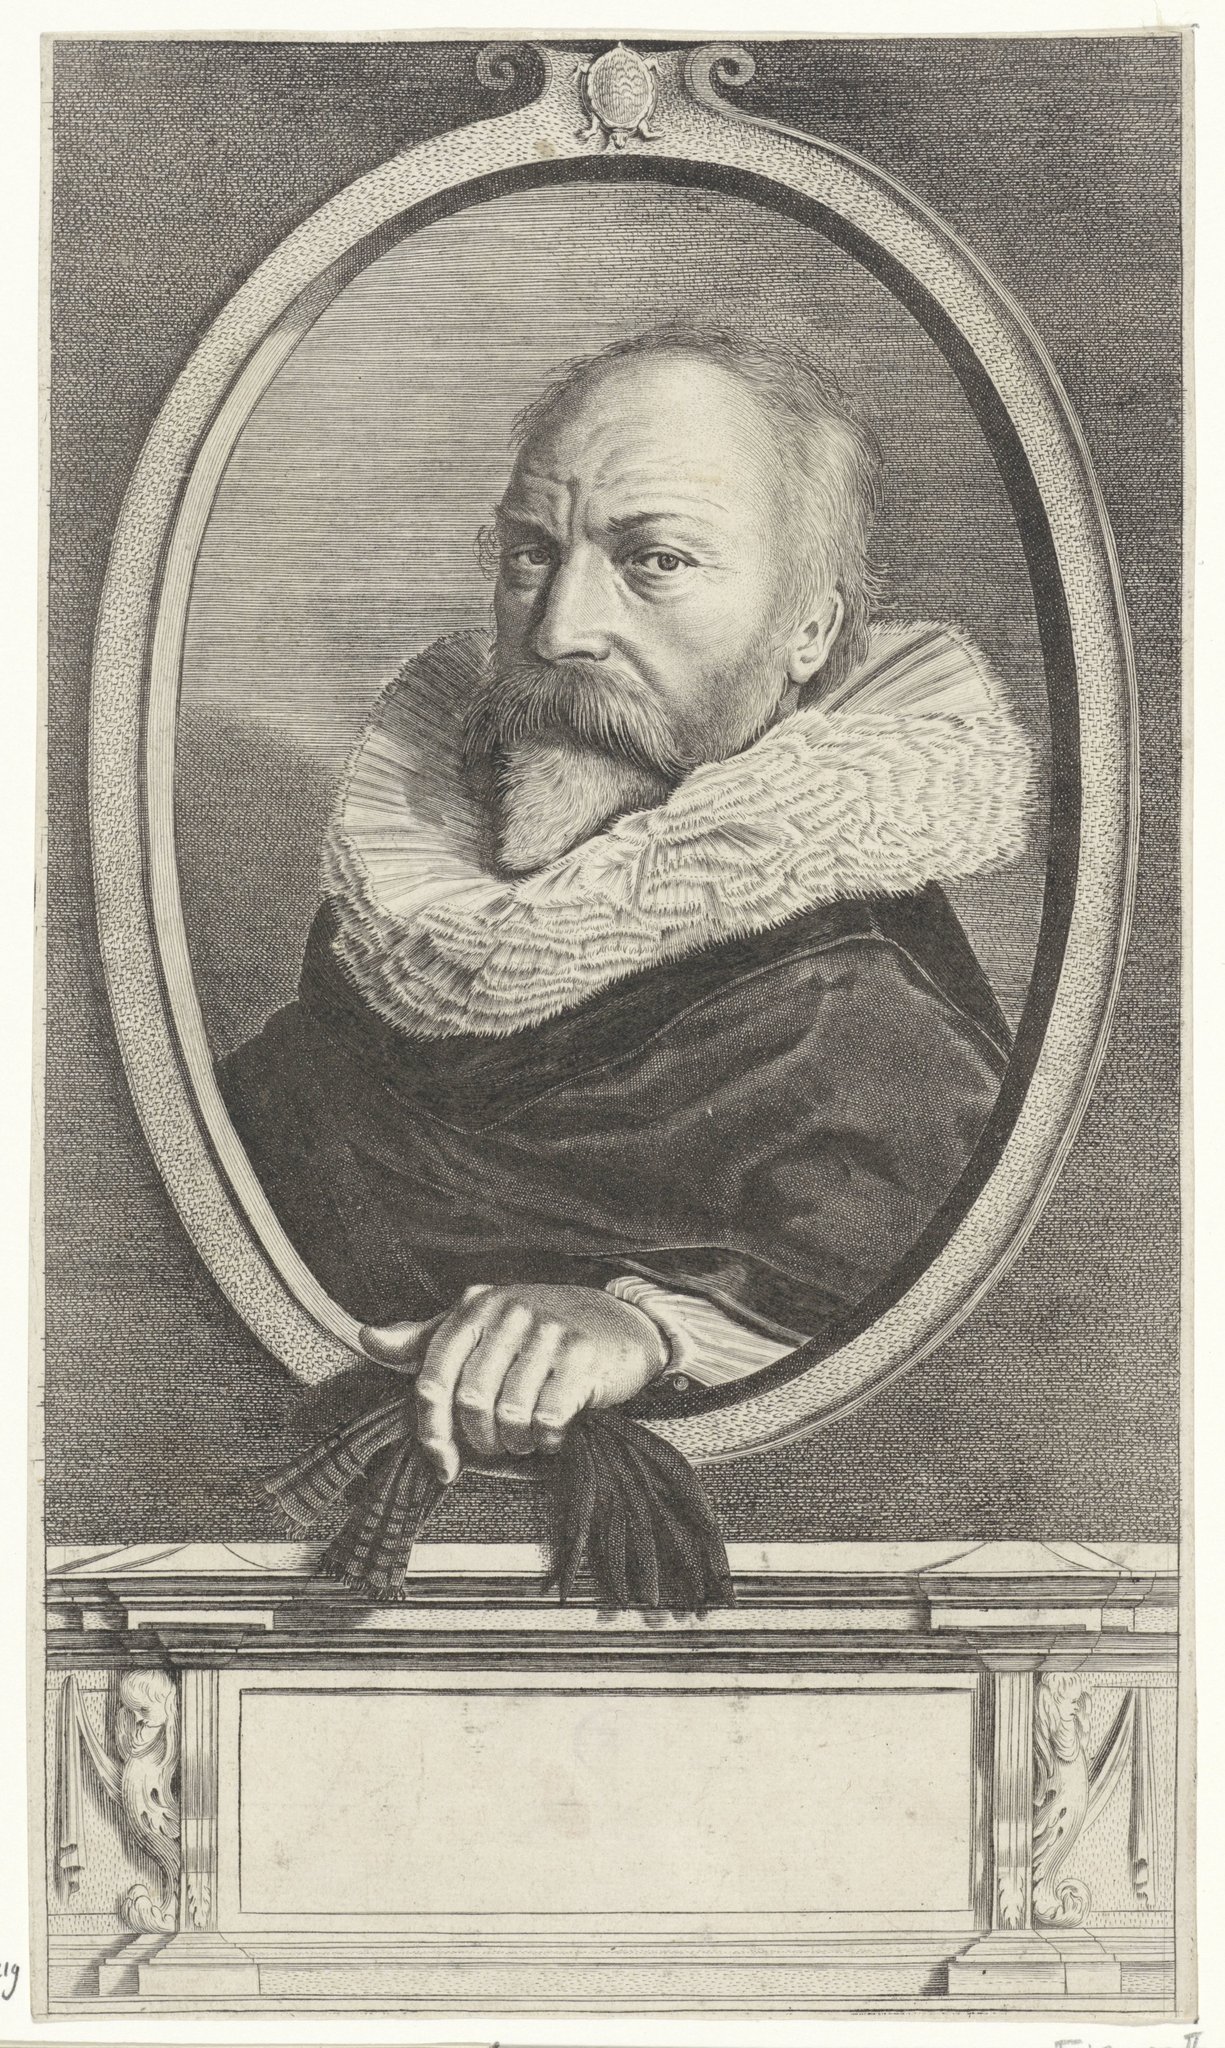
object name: print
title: Portret van Petrus Scriverius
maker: jan van de velde (ii)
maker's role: draughtsman, painter, print maker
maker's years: 1593-1641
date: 1626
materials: paper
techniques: engraving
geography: northern netherlands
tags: petrus scriverius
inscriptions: collector's mark: Lugt 964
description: Portret van de geschiedkundige en schrijver Petrus Scriverius.